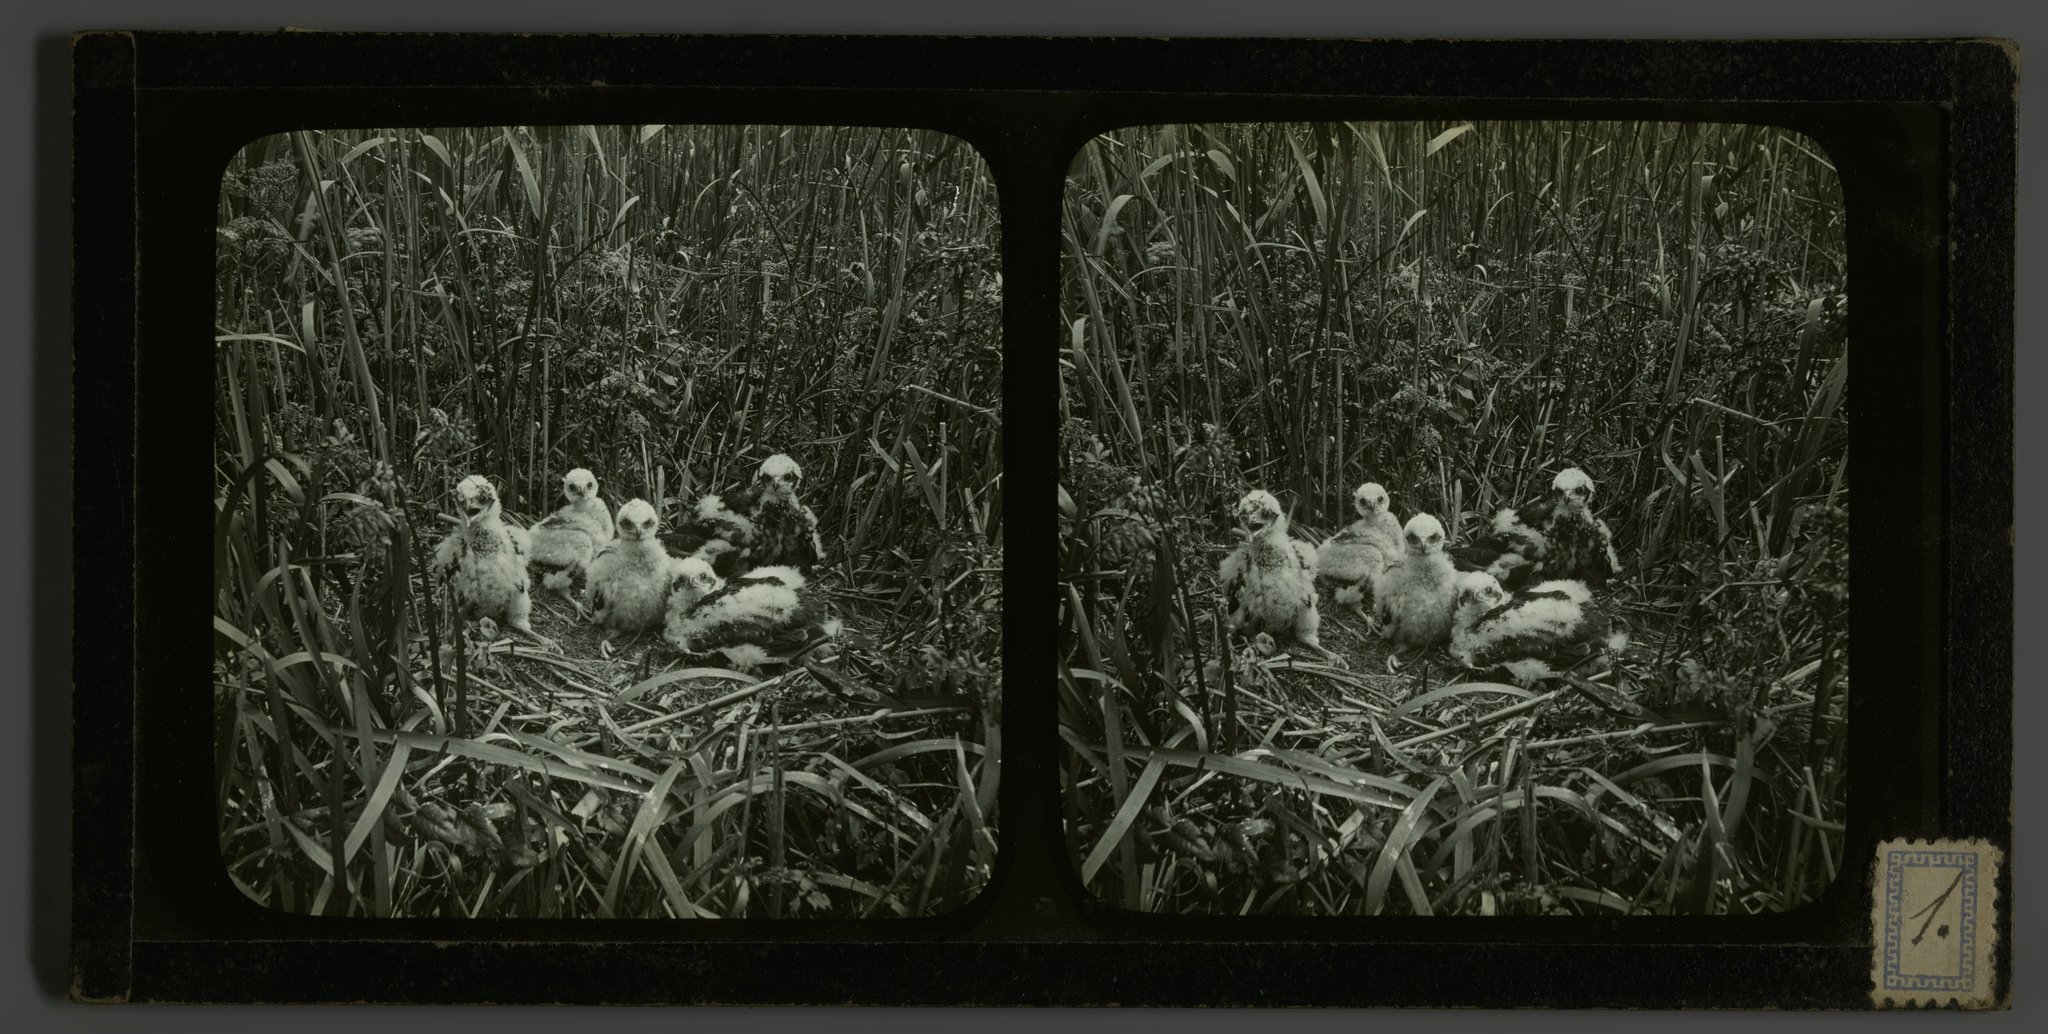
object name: stereoscopic photograph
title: Jonge roofvogels op een nest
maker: Anonymous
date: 1856-1890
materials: glass, paper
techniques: slide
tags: predatory birds (+ young animal)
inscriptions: number: ‘1’